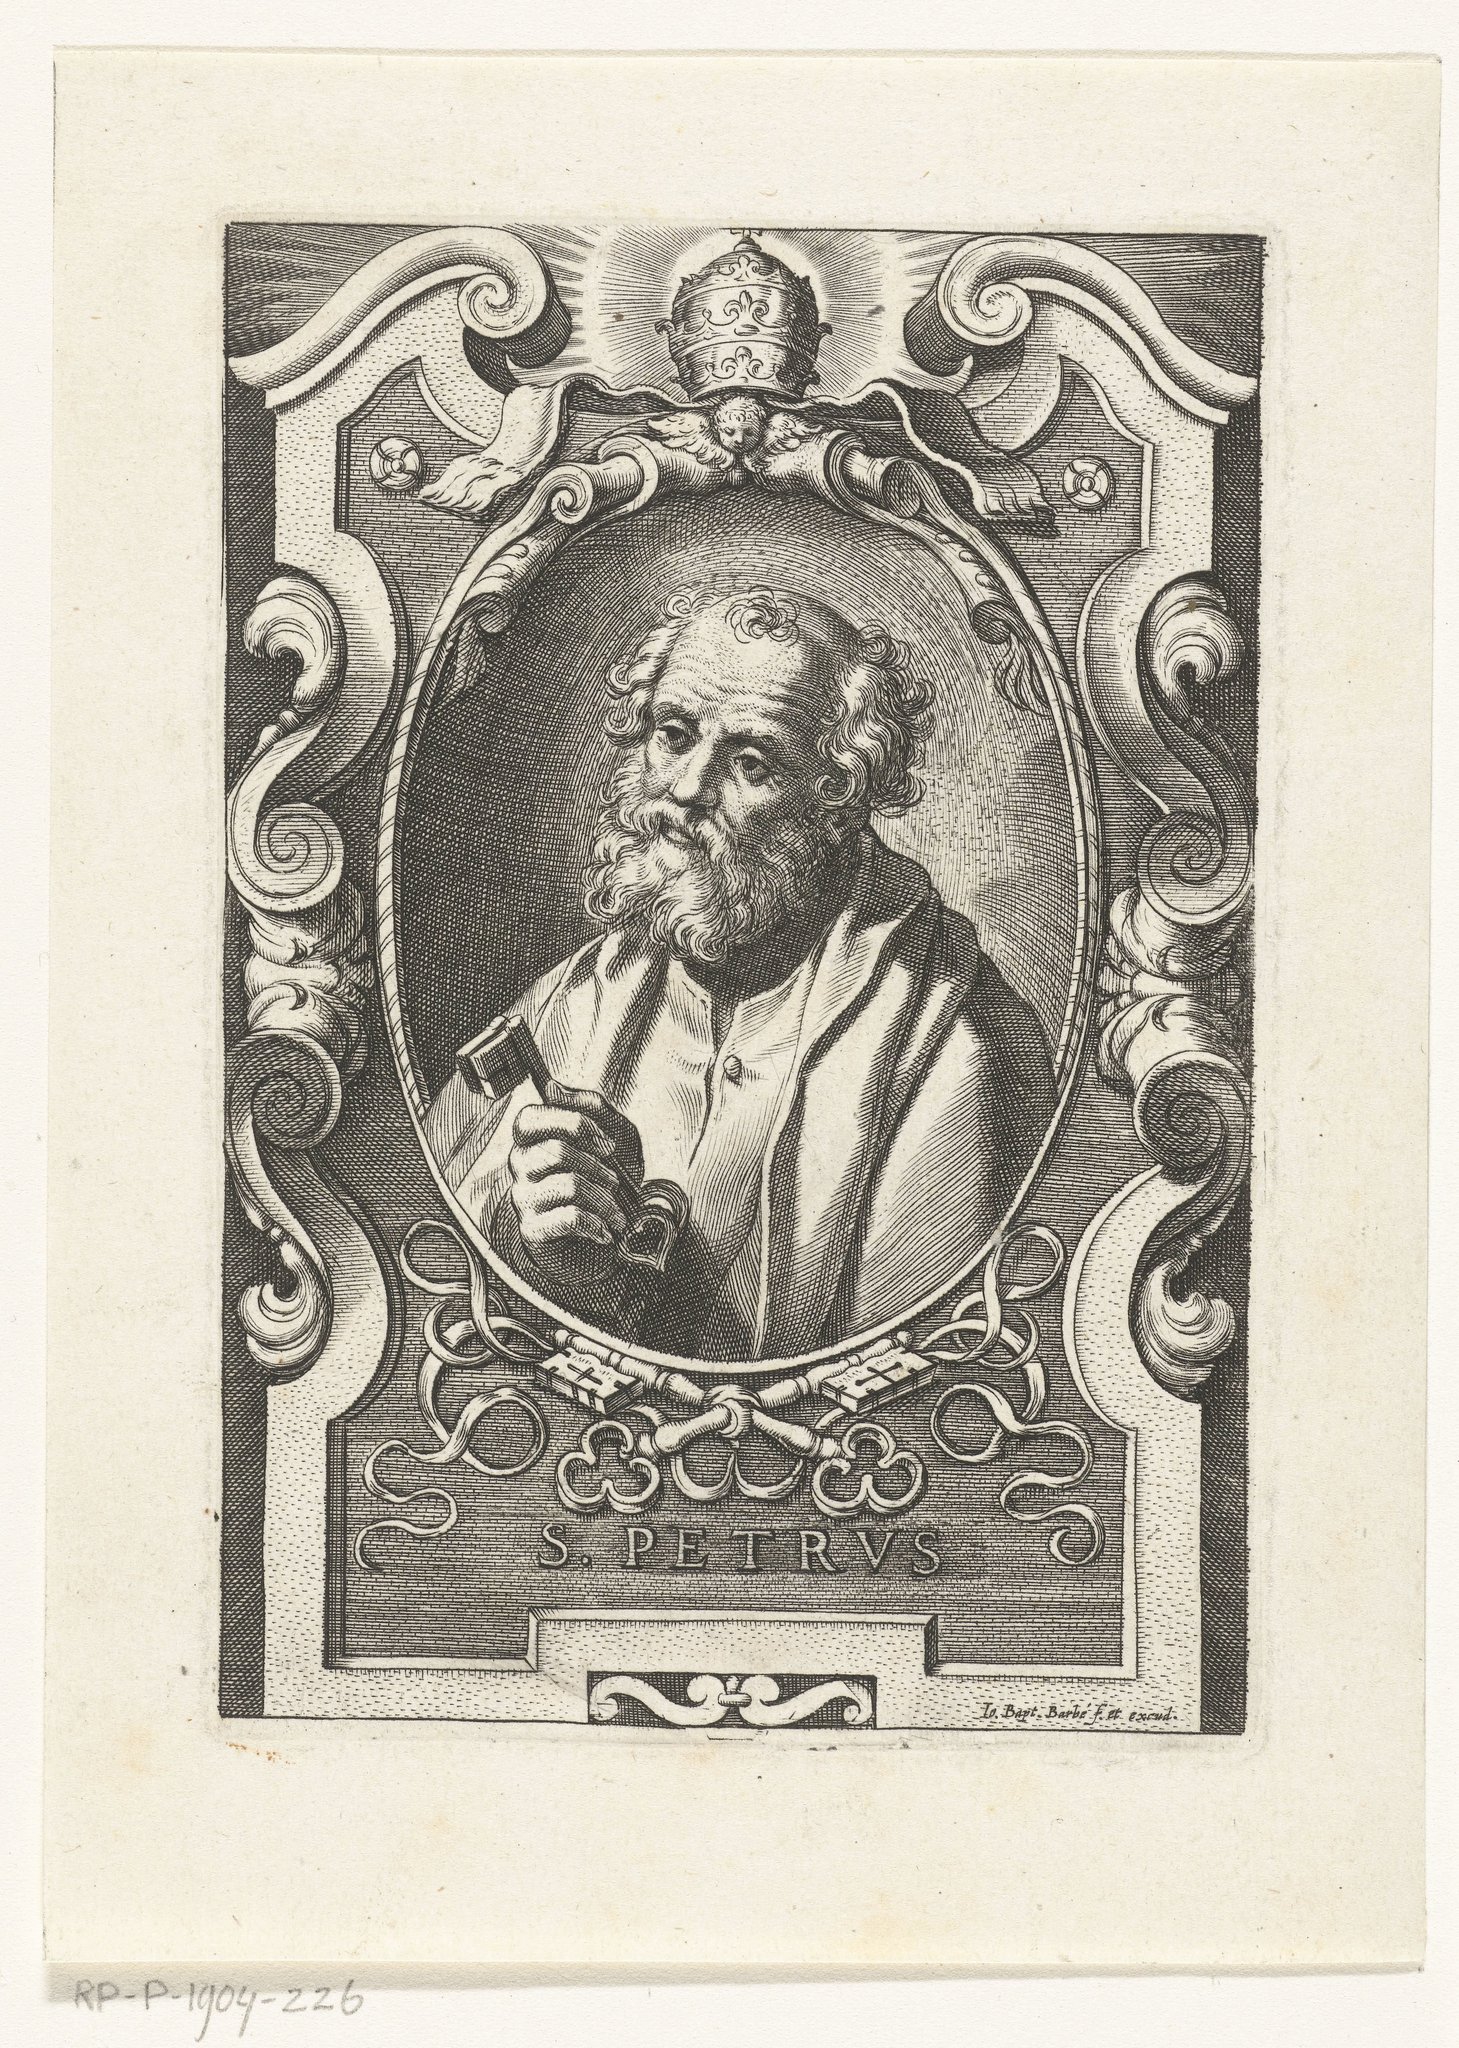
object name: print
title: S. Pertvs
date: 1588-1648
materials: paper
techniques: engraving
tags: ornament derived from architectural details, the apostle peter, first bishop of rome; possible attributes: book, cock, (upturned) cross, (triple) crozier, fish, key, scroll, ship, tiara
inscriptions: collector's mark: Lugt 2228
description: Prent uit: SS. Apostolorum et Evangelistorum Icones, Jean Baptiste Barbé (uitgever). Prent naar tekening van Nicolaas van der Horst.